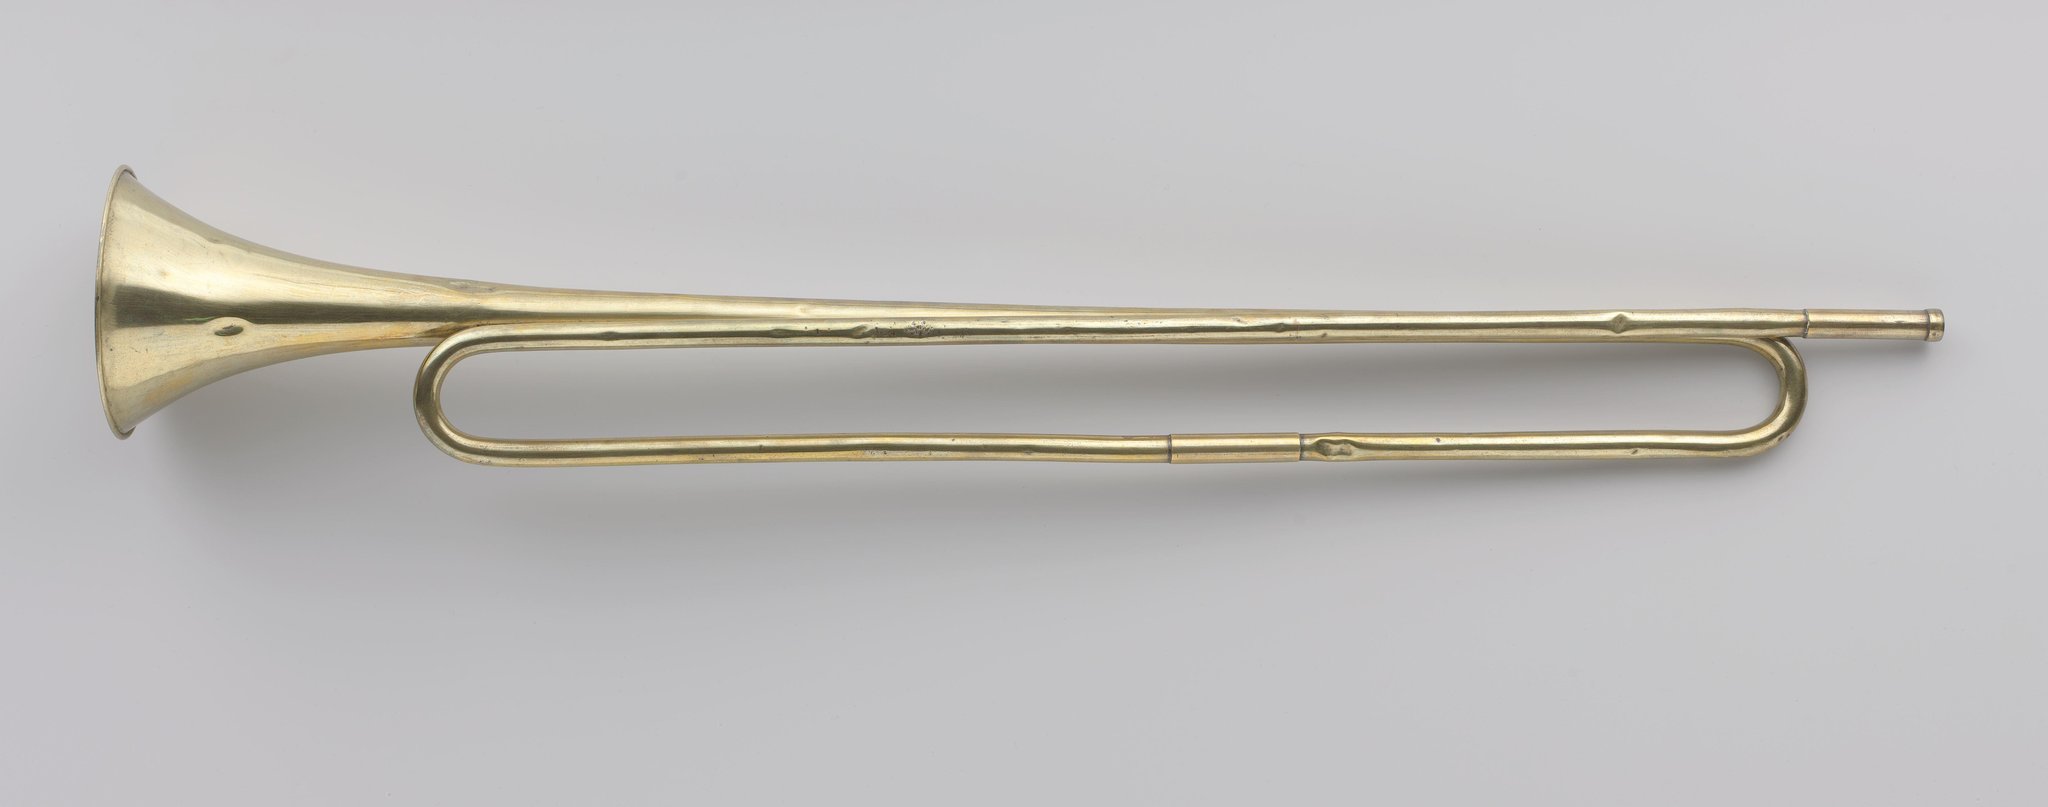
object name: musical instrument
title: Natural trumpet (signal trumpet)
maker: Anonymous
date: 1800-1830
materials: copper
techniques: casting, sawing, soldering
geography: netherlands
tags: belgium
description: Trompet van J. Passier, in 1830-1832 trompetter afdeling kurassiers nr. 9, ridder militaire Willemsorde 4e klasse.